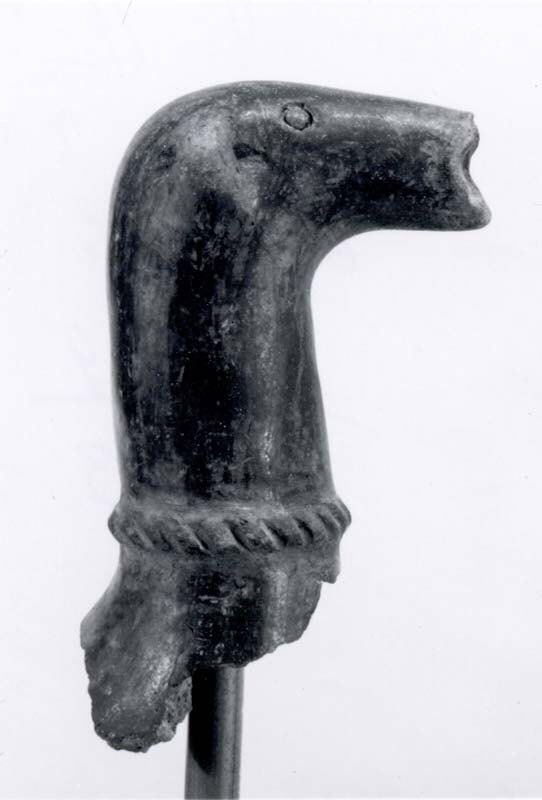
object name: spout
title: Jar spout with animal head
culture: iranian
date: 900-801 BCE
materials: ceramic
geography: iran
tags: animals